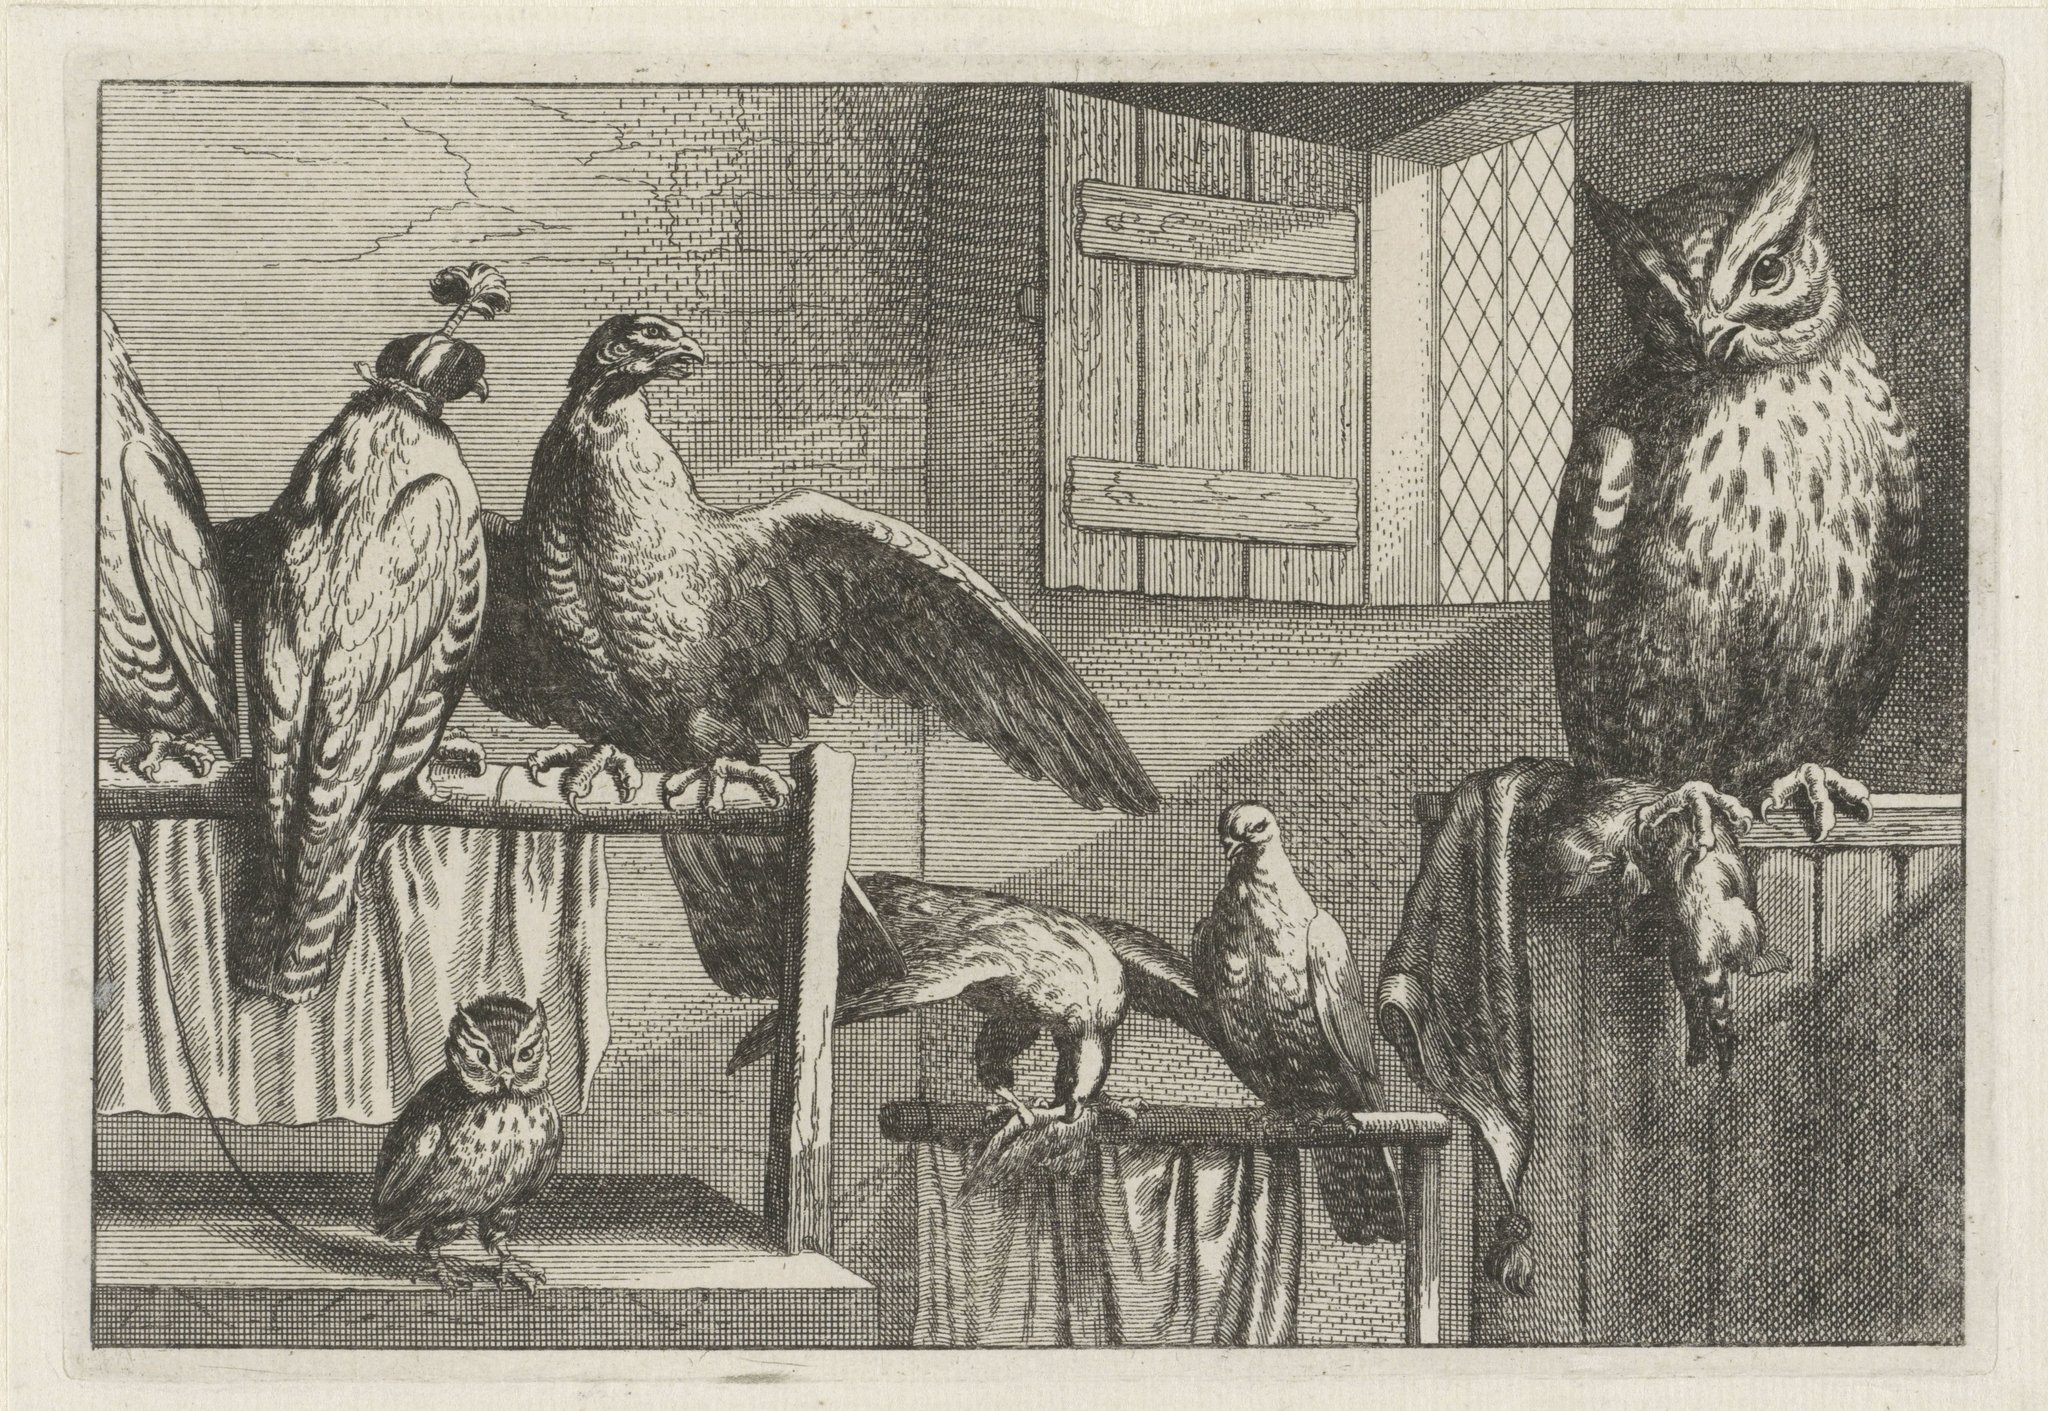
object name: print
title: Valk en uilen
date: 1662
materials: paper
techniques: etching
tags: predatory birds: falcon